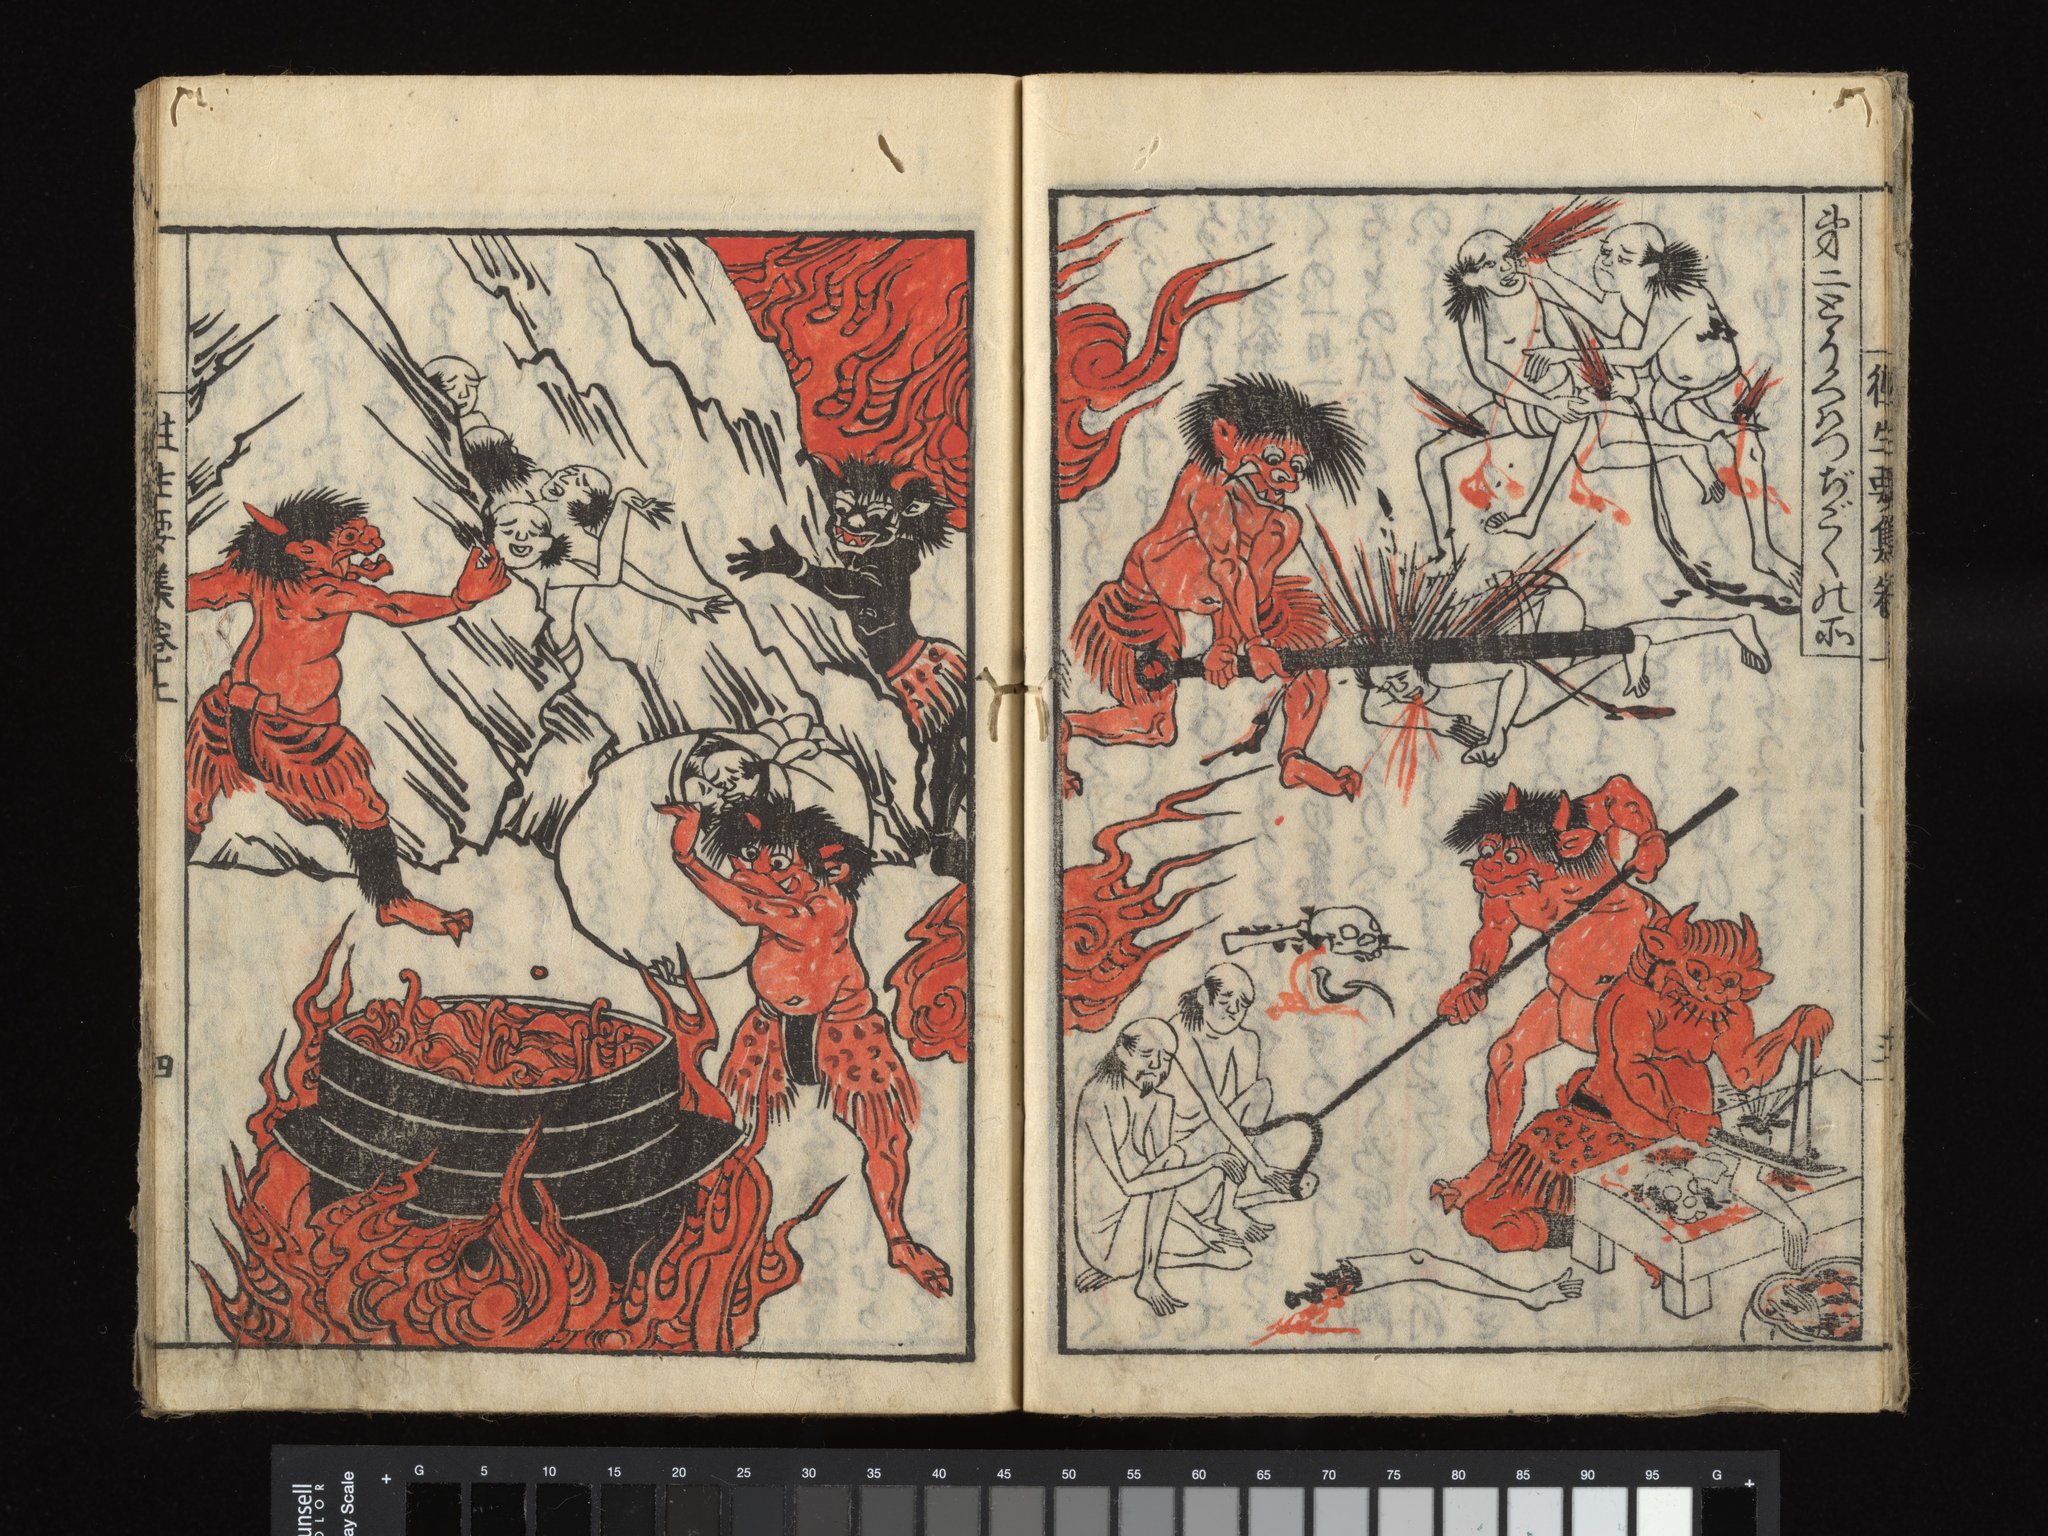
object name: illustrated book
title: The Essentials of Rebirth in the Pure Land (Ojōyōshū)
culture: japanese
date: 1790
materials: ink, paper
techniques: woodblock print